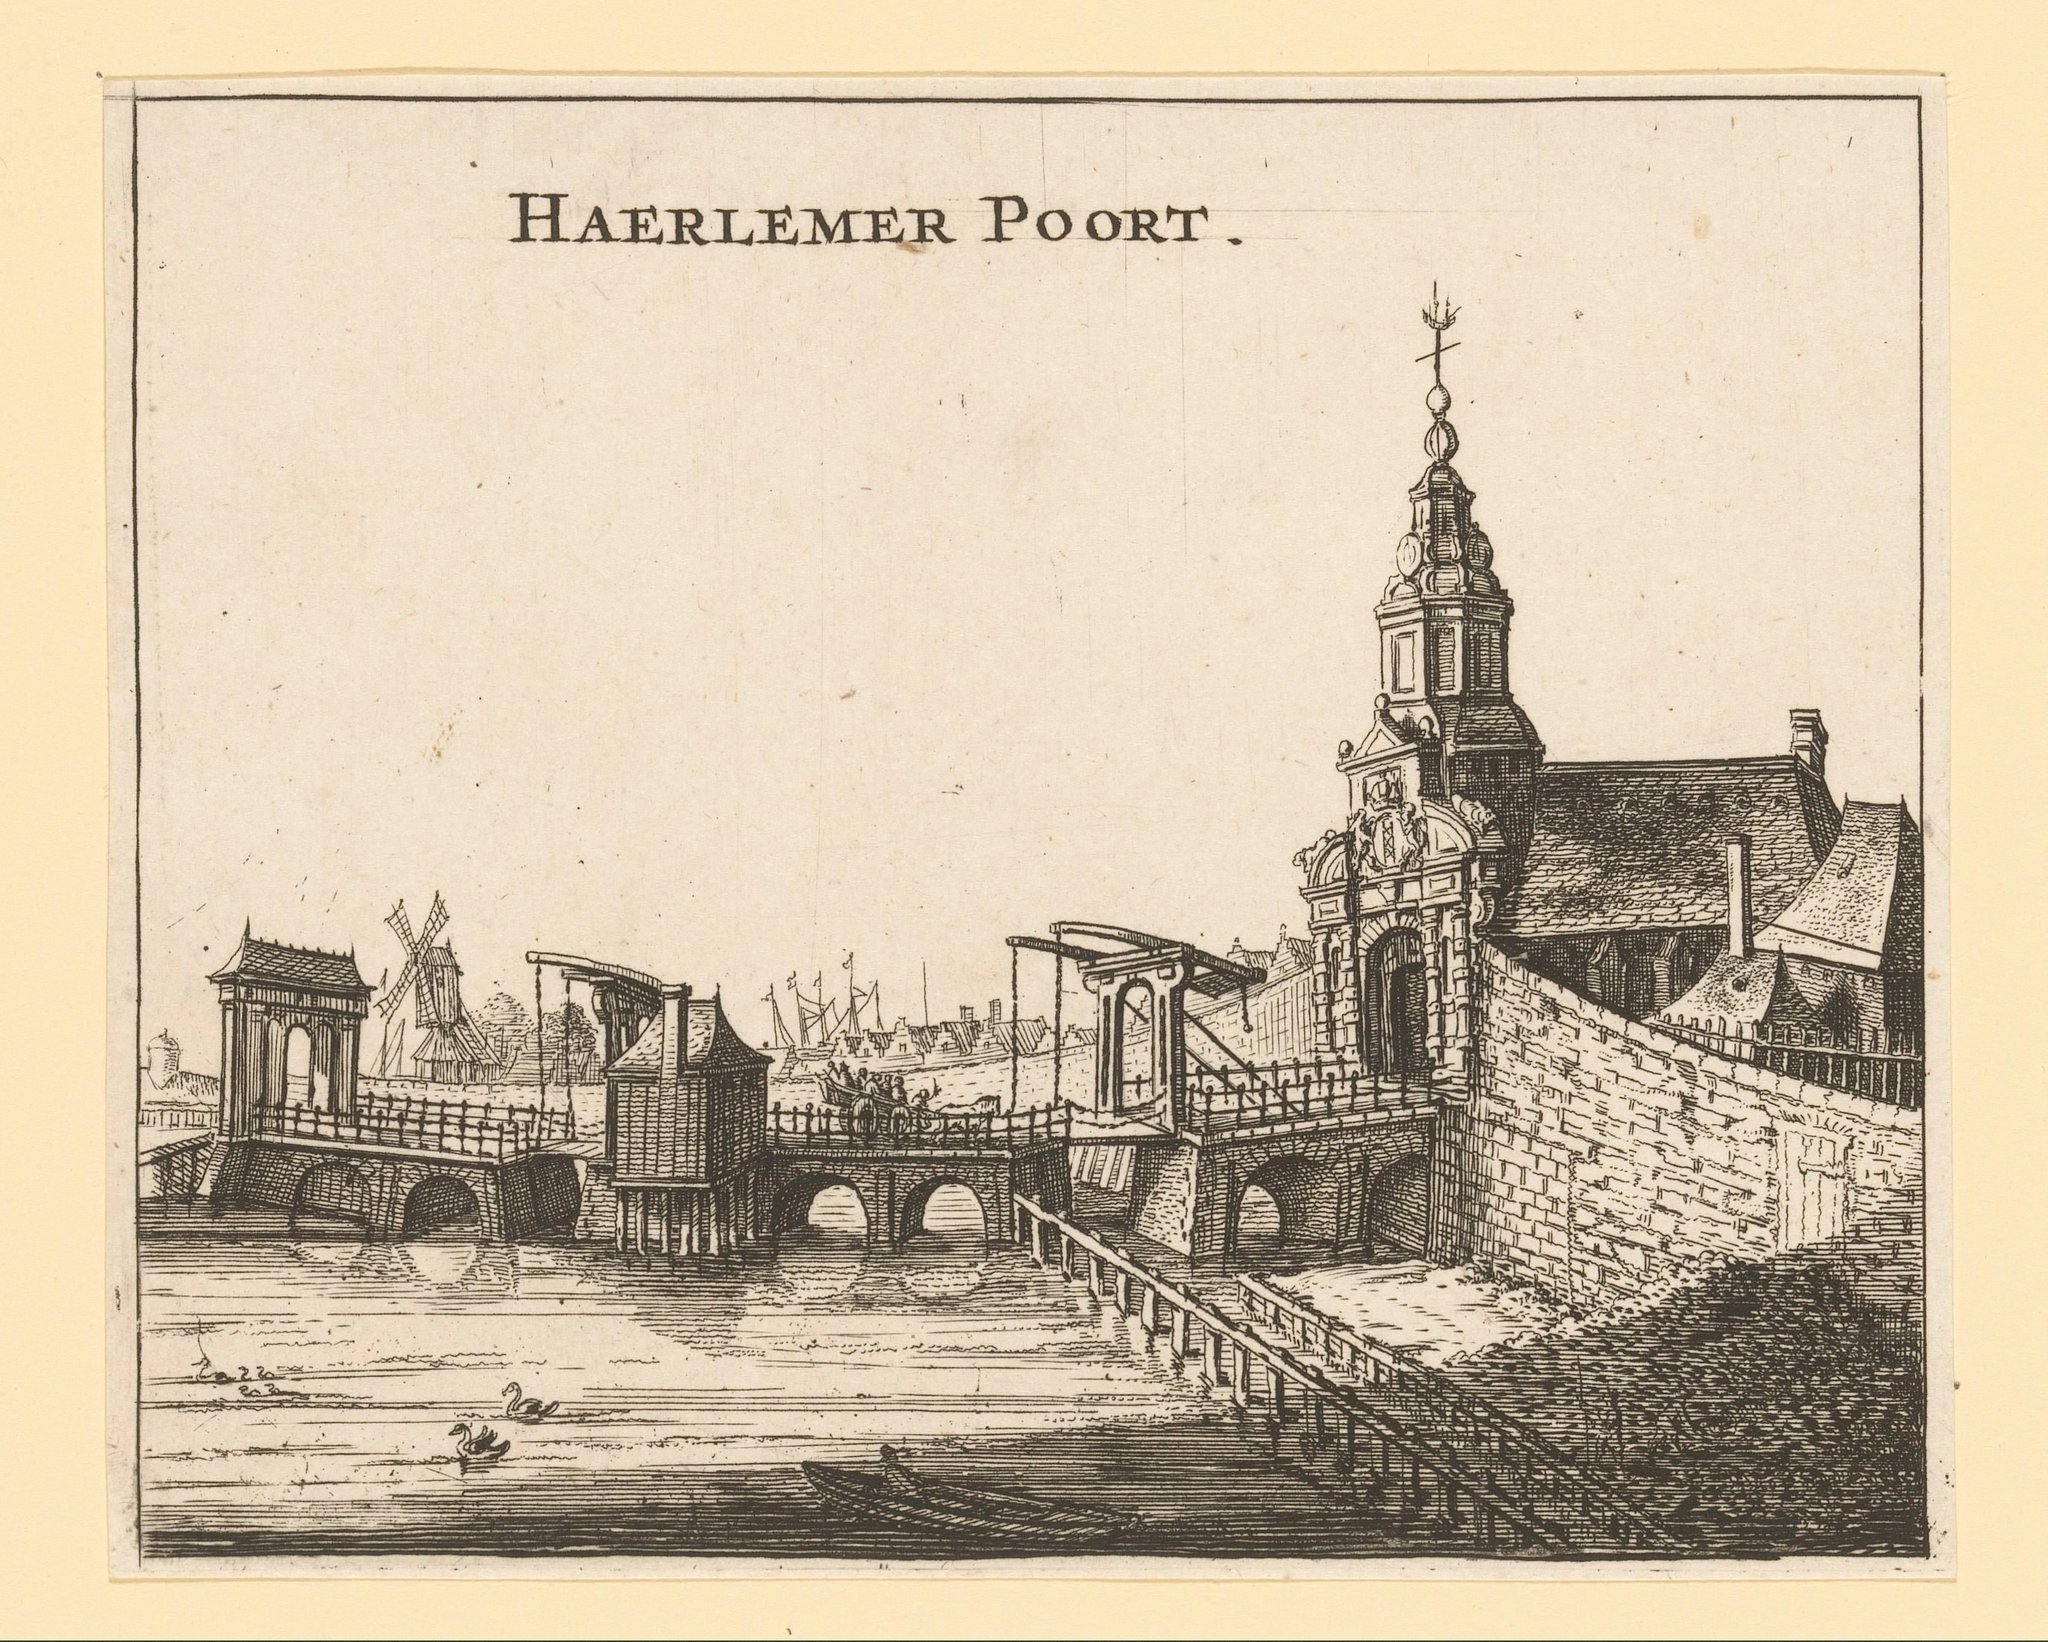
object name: print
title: Gezicht op de Haarlemmerpoort te Amsterdam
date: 1664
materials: paper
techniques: engraving, etching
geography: amsterdam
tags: bridge, city-gate, canal (+ landscape with figures, staffage)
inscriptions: collector's mark: Lugt 195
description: Huidige staat van prent ook gebruikt in: Fockens, Melchior. Beschrijving Der wijdt-vermaarde Koop-stadt Amstelredam, Van haar eerste beginselen, zedert den Jare 1203. oude Voorrechten, verscheyde Vergrootingenoude Voor-rechten, en verscheyde Vergrootingen (…). 3e druk. Amsterdam: Marcus Willemsz. Doornick, 1664. En in: Zesen, Philipp von. Beschrybung der Weidtberuhmde Kauf-Stadt Amstelredam / Beschreibung der Stadt Amsterdam darinnen von derselben ersten ursprunge bis auf gegenwartigen zustand (…). Amsterdam: Marcus Willemsz. Doornick, 1664. Tweede bekende staat (met toevoeging Franse titel) ook gebruikt in: Domselaer, Tobias en Isaac Commelin. Beschryvinge van Amsterdam : haar eerste oorspronk uyt den huyze der heeren van Aemstel en Aemstellant (…). 6 delen. Amsterdam: Marcus Willemsz van Doornick, 1665. Derde bekende staat (rechtsboven genummerd: 64) ook gebruikt in verschillende latere zeventiende- en achttiende-eeuwse publicaties.